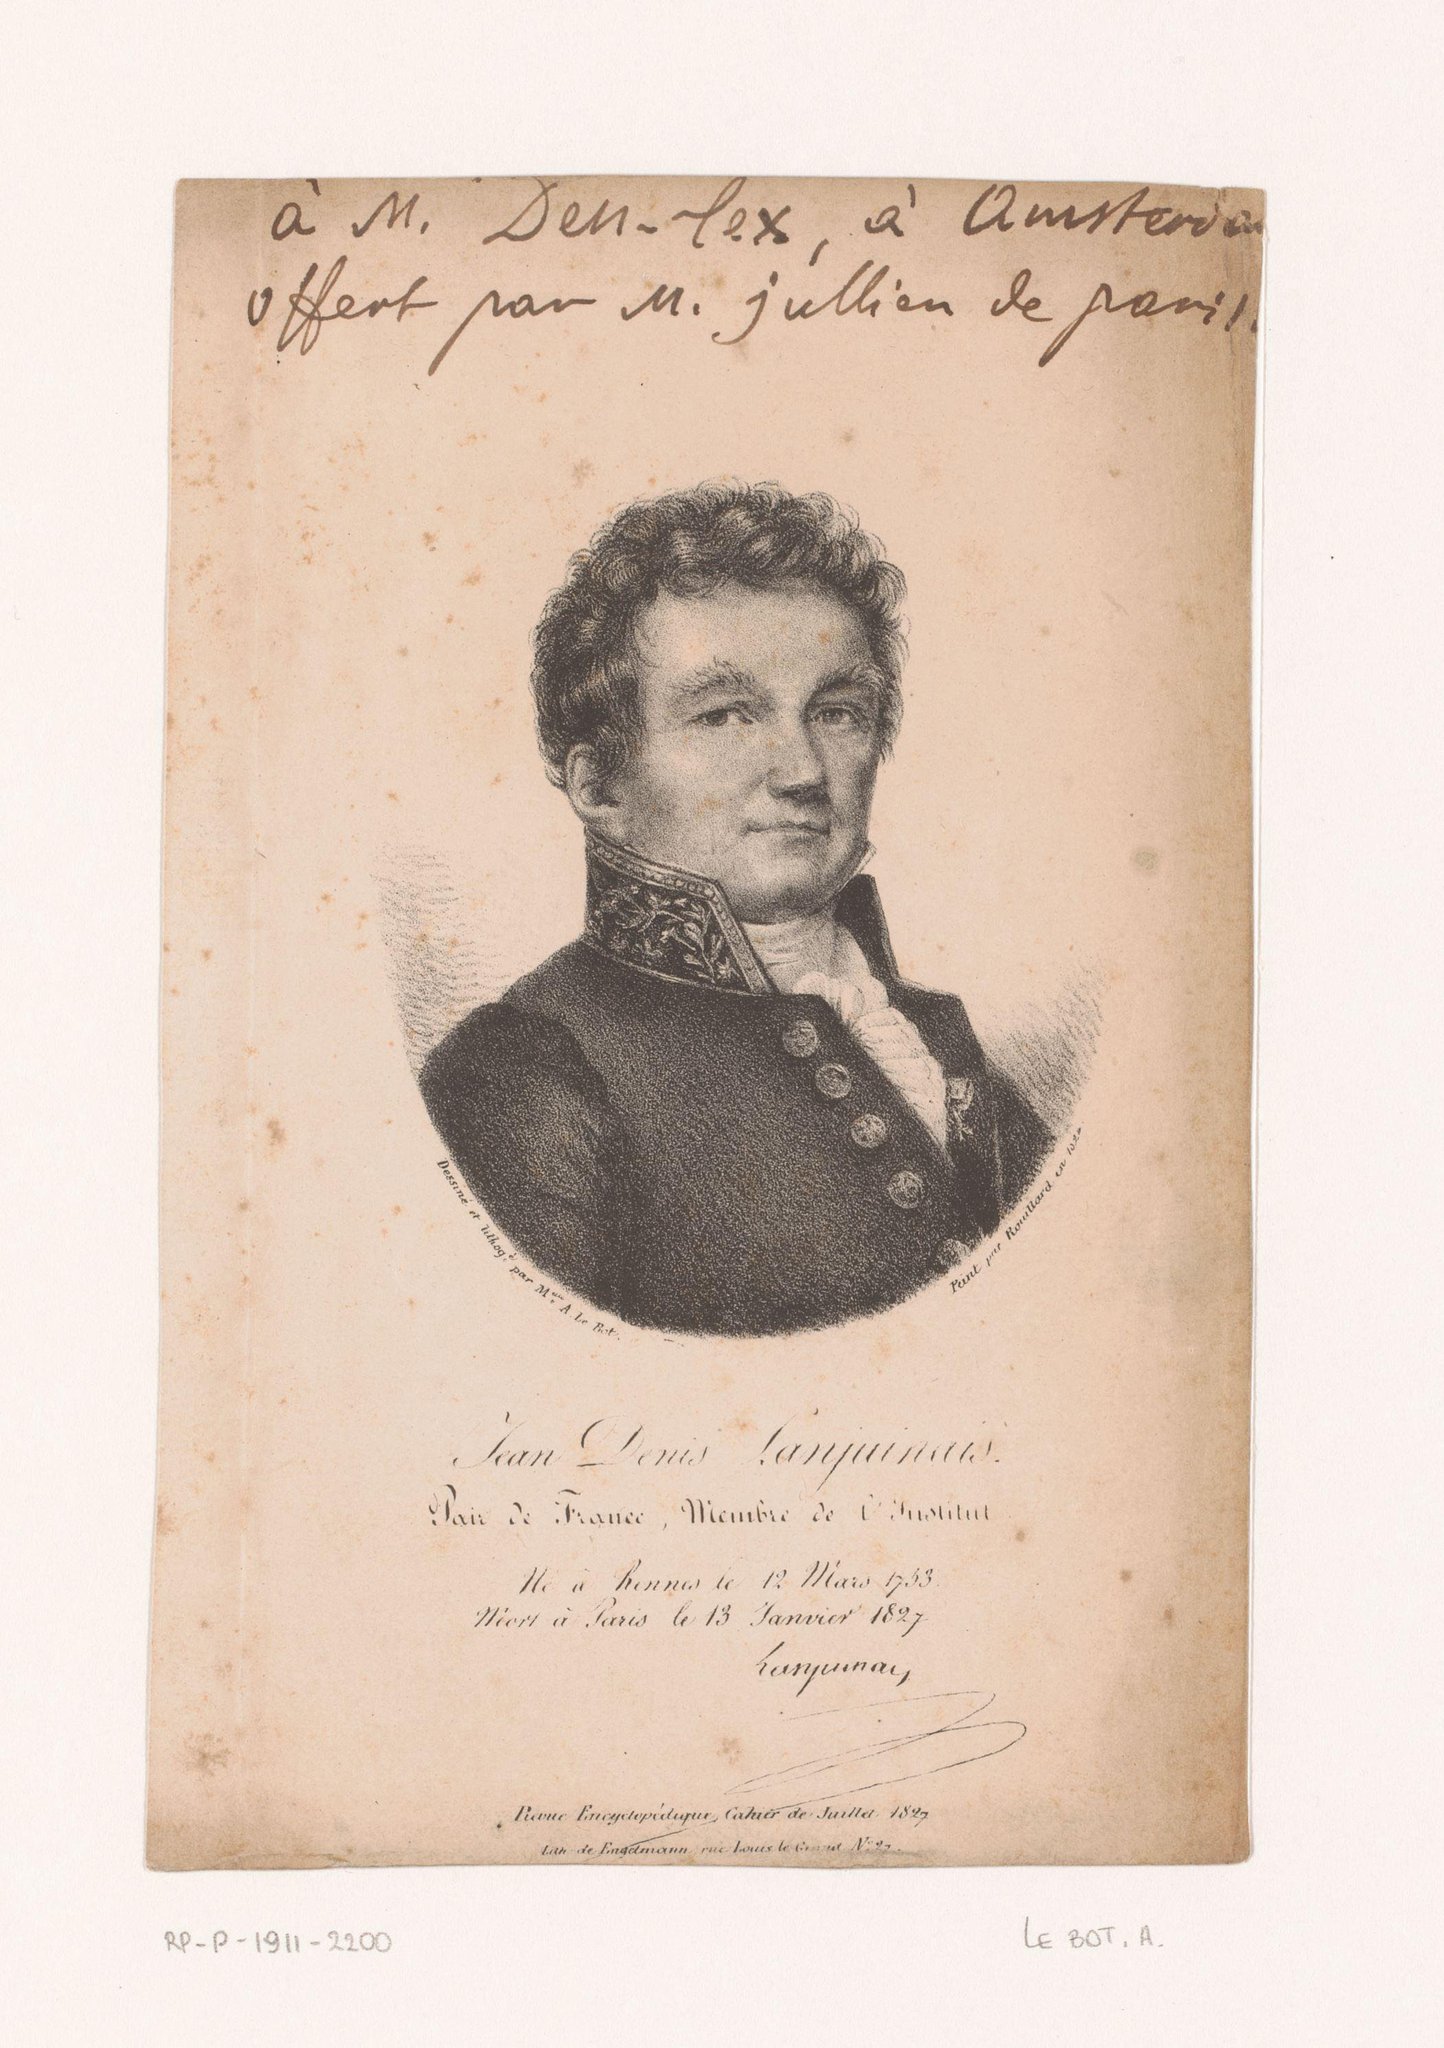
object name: print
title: Jean Denis Lanjuinais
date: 1827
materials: paper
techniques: lithograph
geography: paris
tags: paris, politician, historical persons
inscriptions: collector's mark: Lugt 2228a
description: Prent gebruikt voor: Revue Encyclopédique, cahier de juillet, 1827.